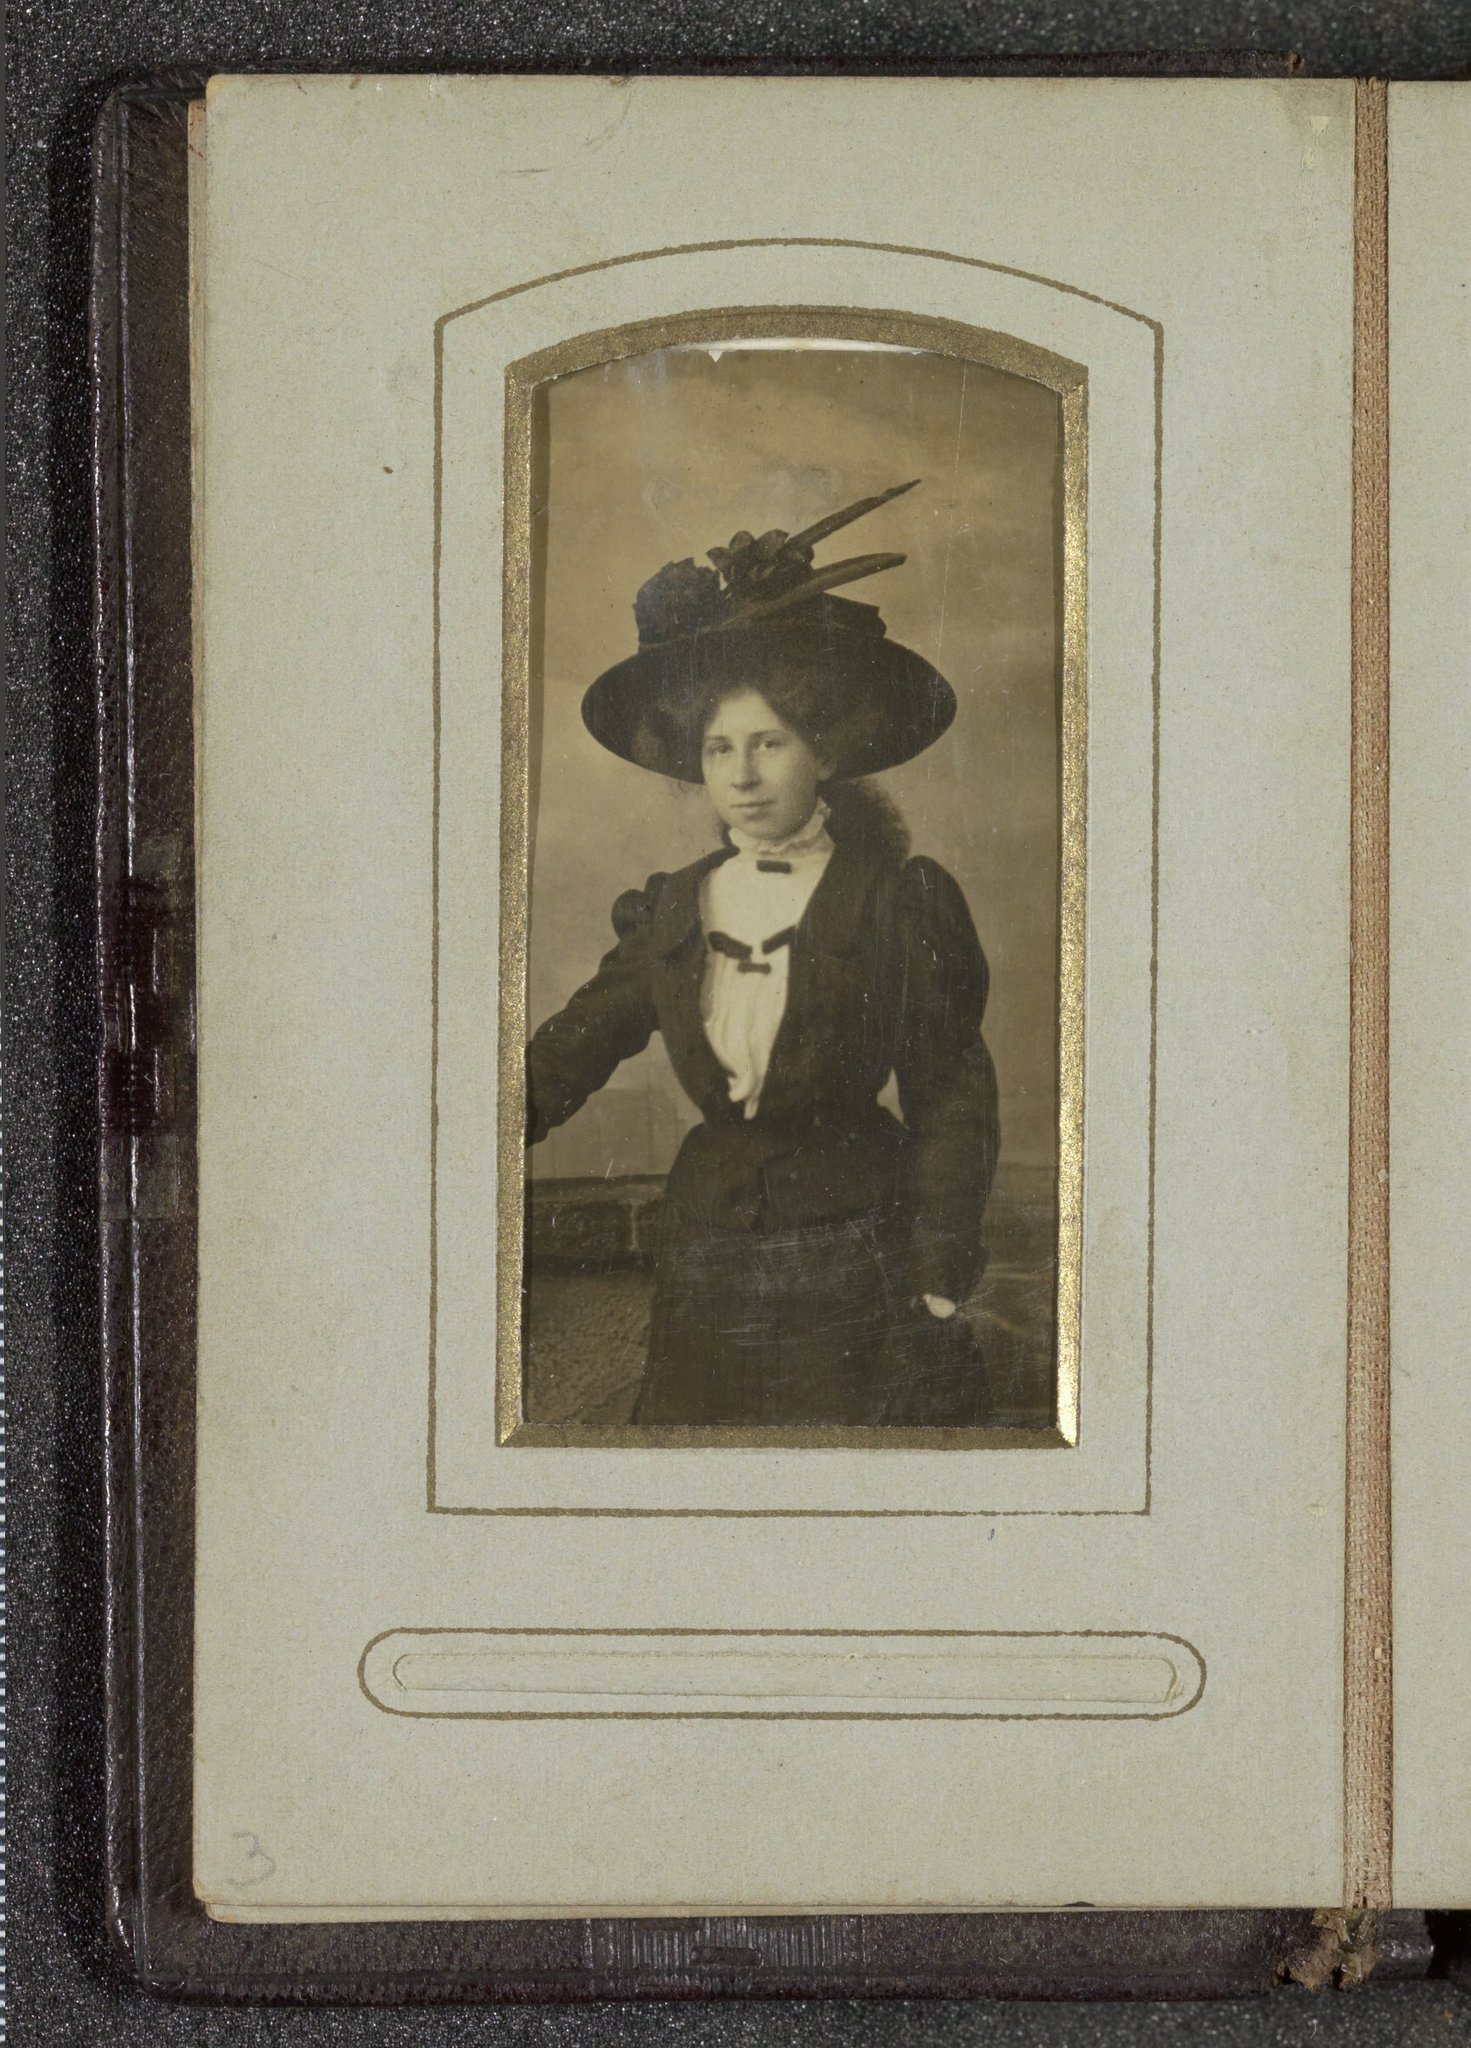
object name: photograph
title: Portret van een jonge vrouw met een hoed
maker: Anonymous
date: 1890-1910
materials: cardboard, paper, photographic support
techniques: gelatin silver print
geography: england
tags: adult woman, head-gear: hat, england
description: Onderdeel van Album met 12 automaatfoto's van een Engelse familie.